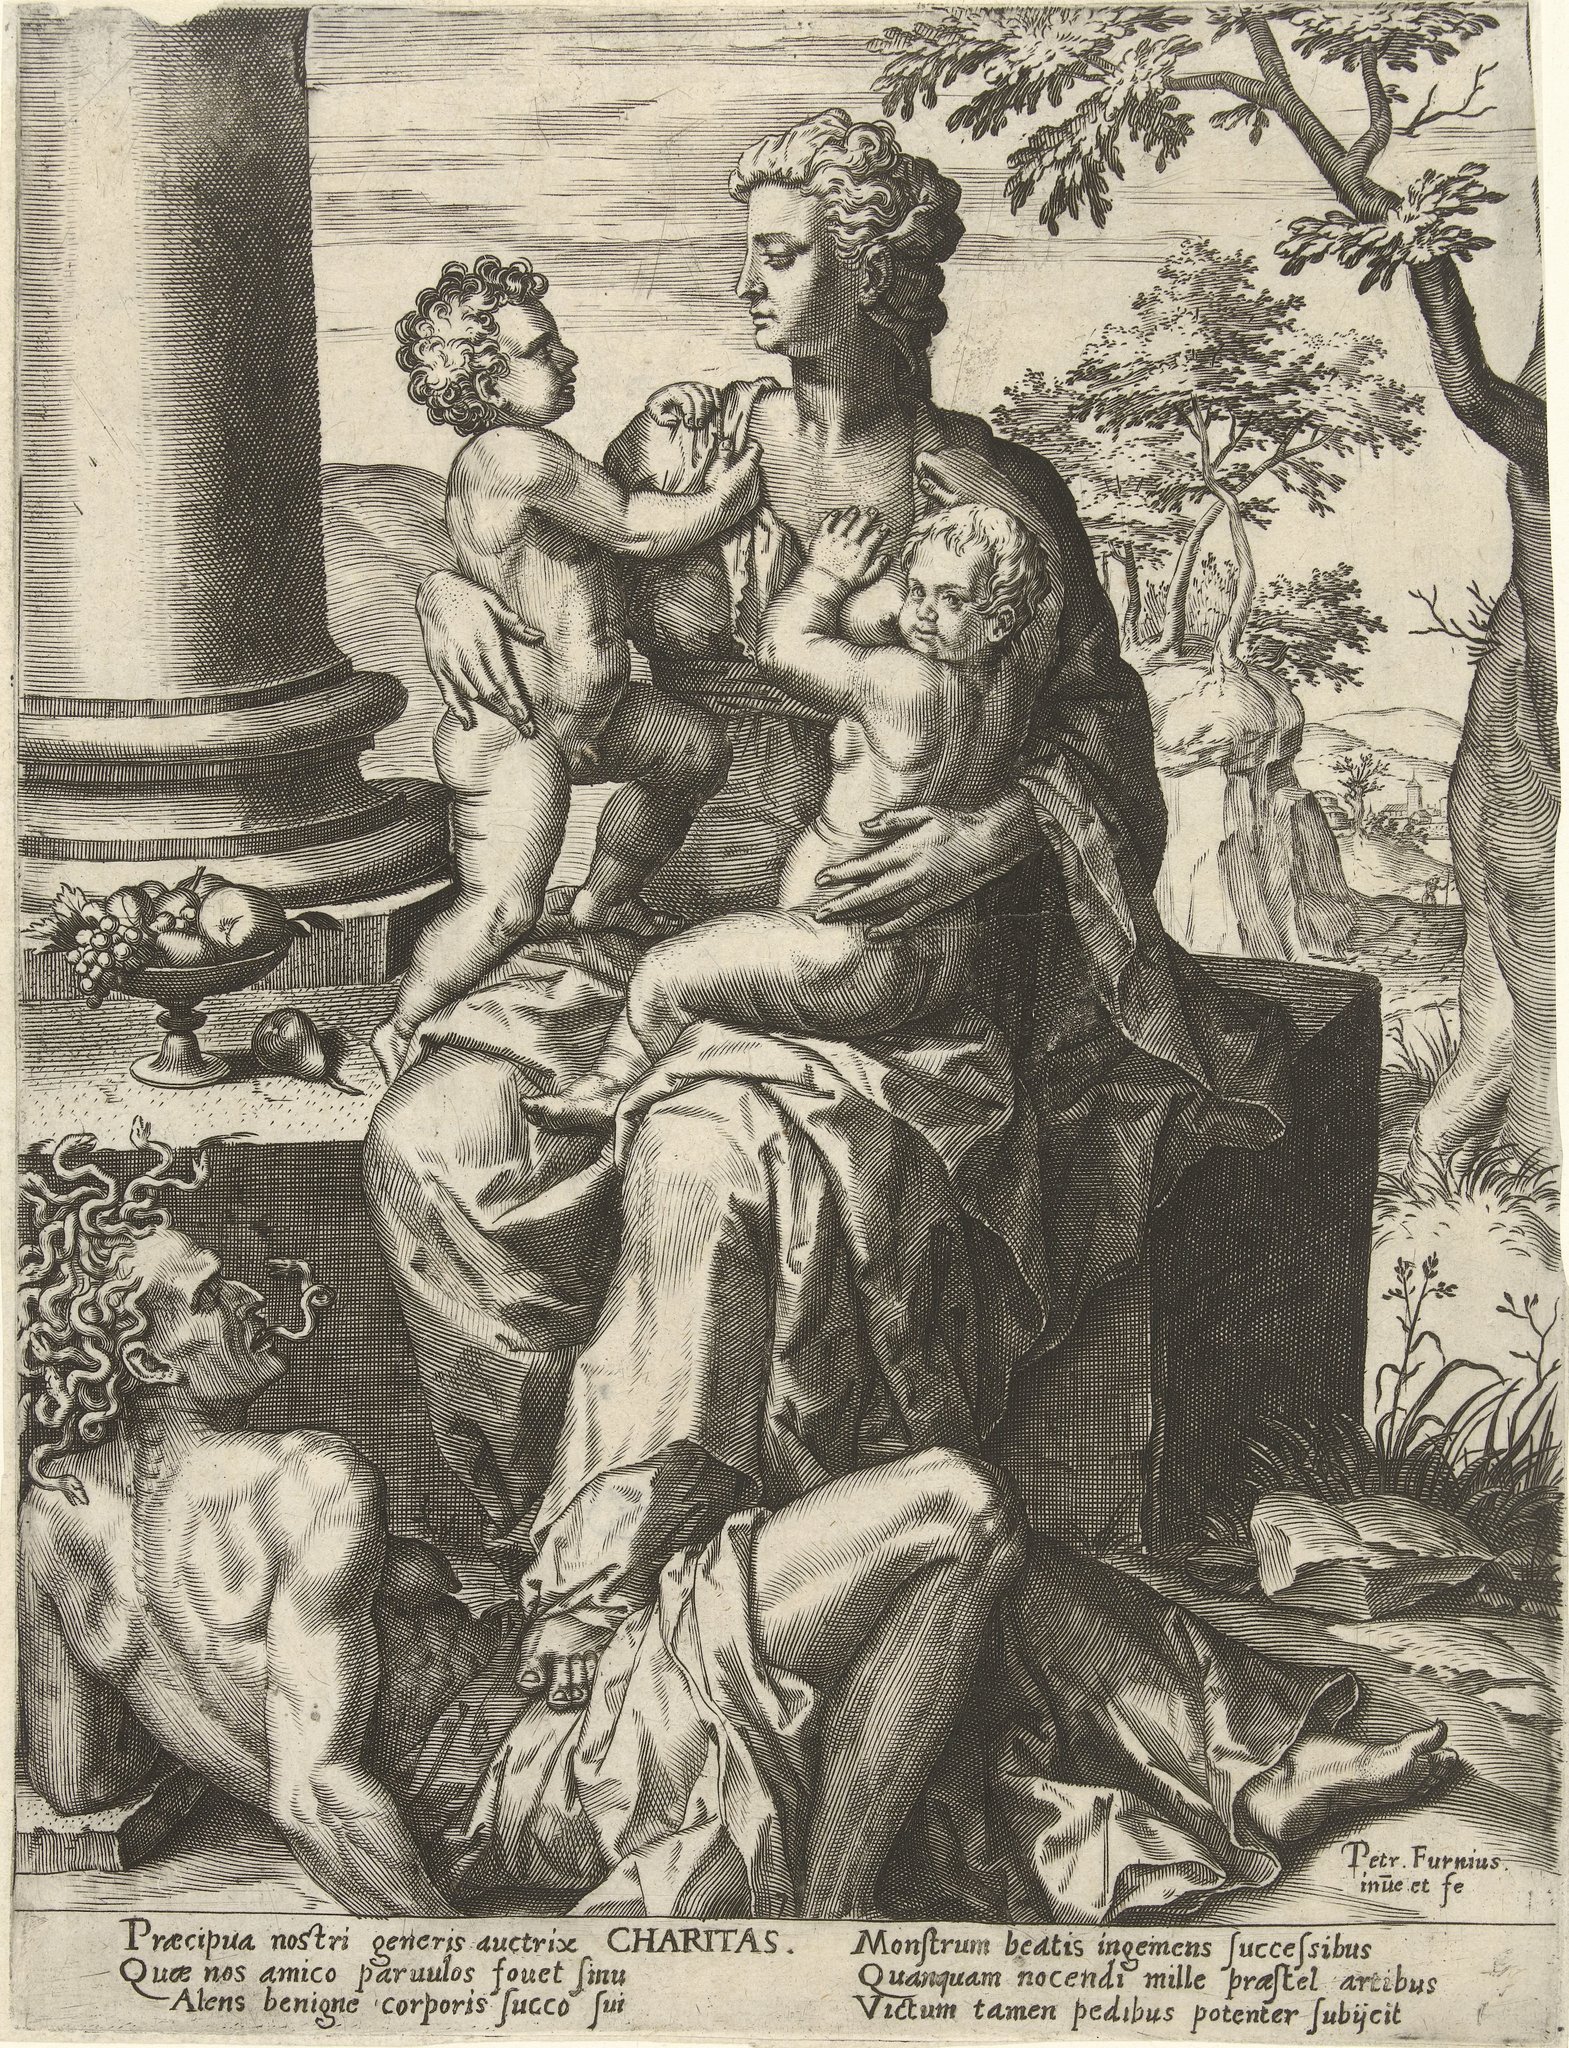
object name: print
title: Liefde overwint Afgunst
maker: pieter jalhea furnius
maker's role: print maker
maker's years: 1540-1626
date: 1550-1625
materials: paper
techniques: engraving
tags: charity, 'caritas'; 'carità' (ripa) ~ one of the three theological virtues, envy; 'invidia' (ripa) ~ personification of one of the seven deadly sins, one virtue fighting against or treading upon one vice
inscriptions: collector's mark: Lugt 2228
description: De personificatie van de Liefde (Caritas) zit met twee kleine kinderen op haar schoot en vertrapt de Afgunst (Invidia). De prent heeft een Latijns onderschrift en maakt deel uit van een serie over deugden en ondeugden.